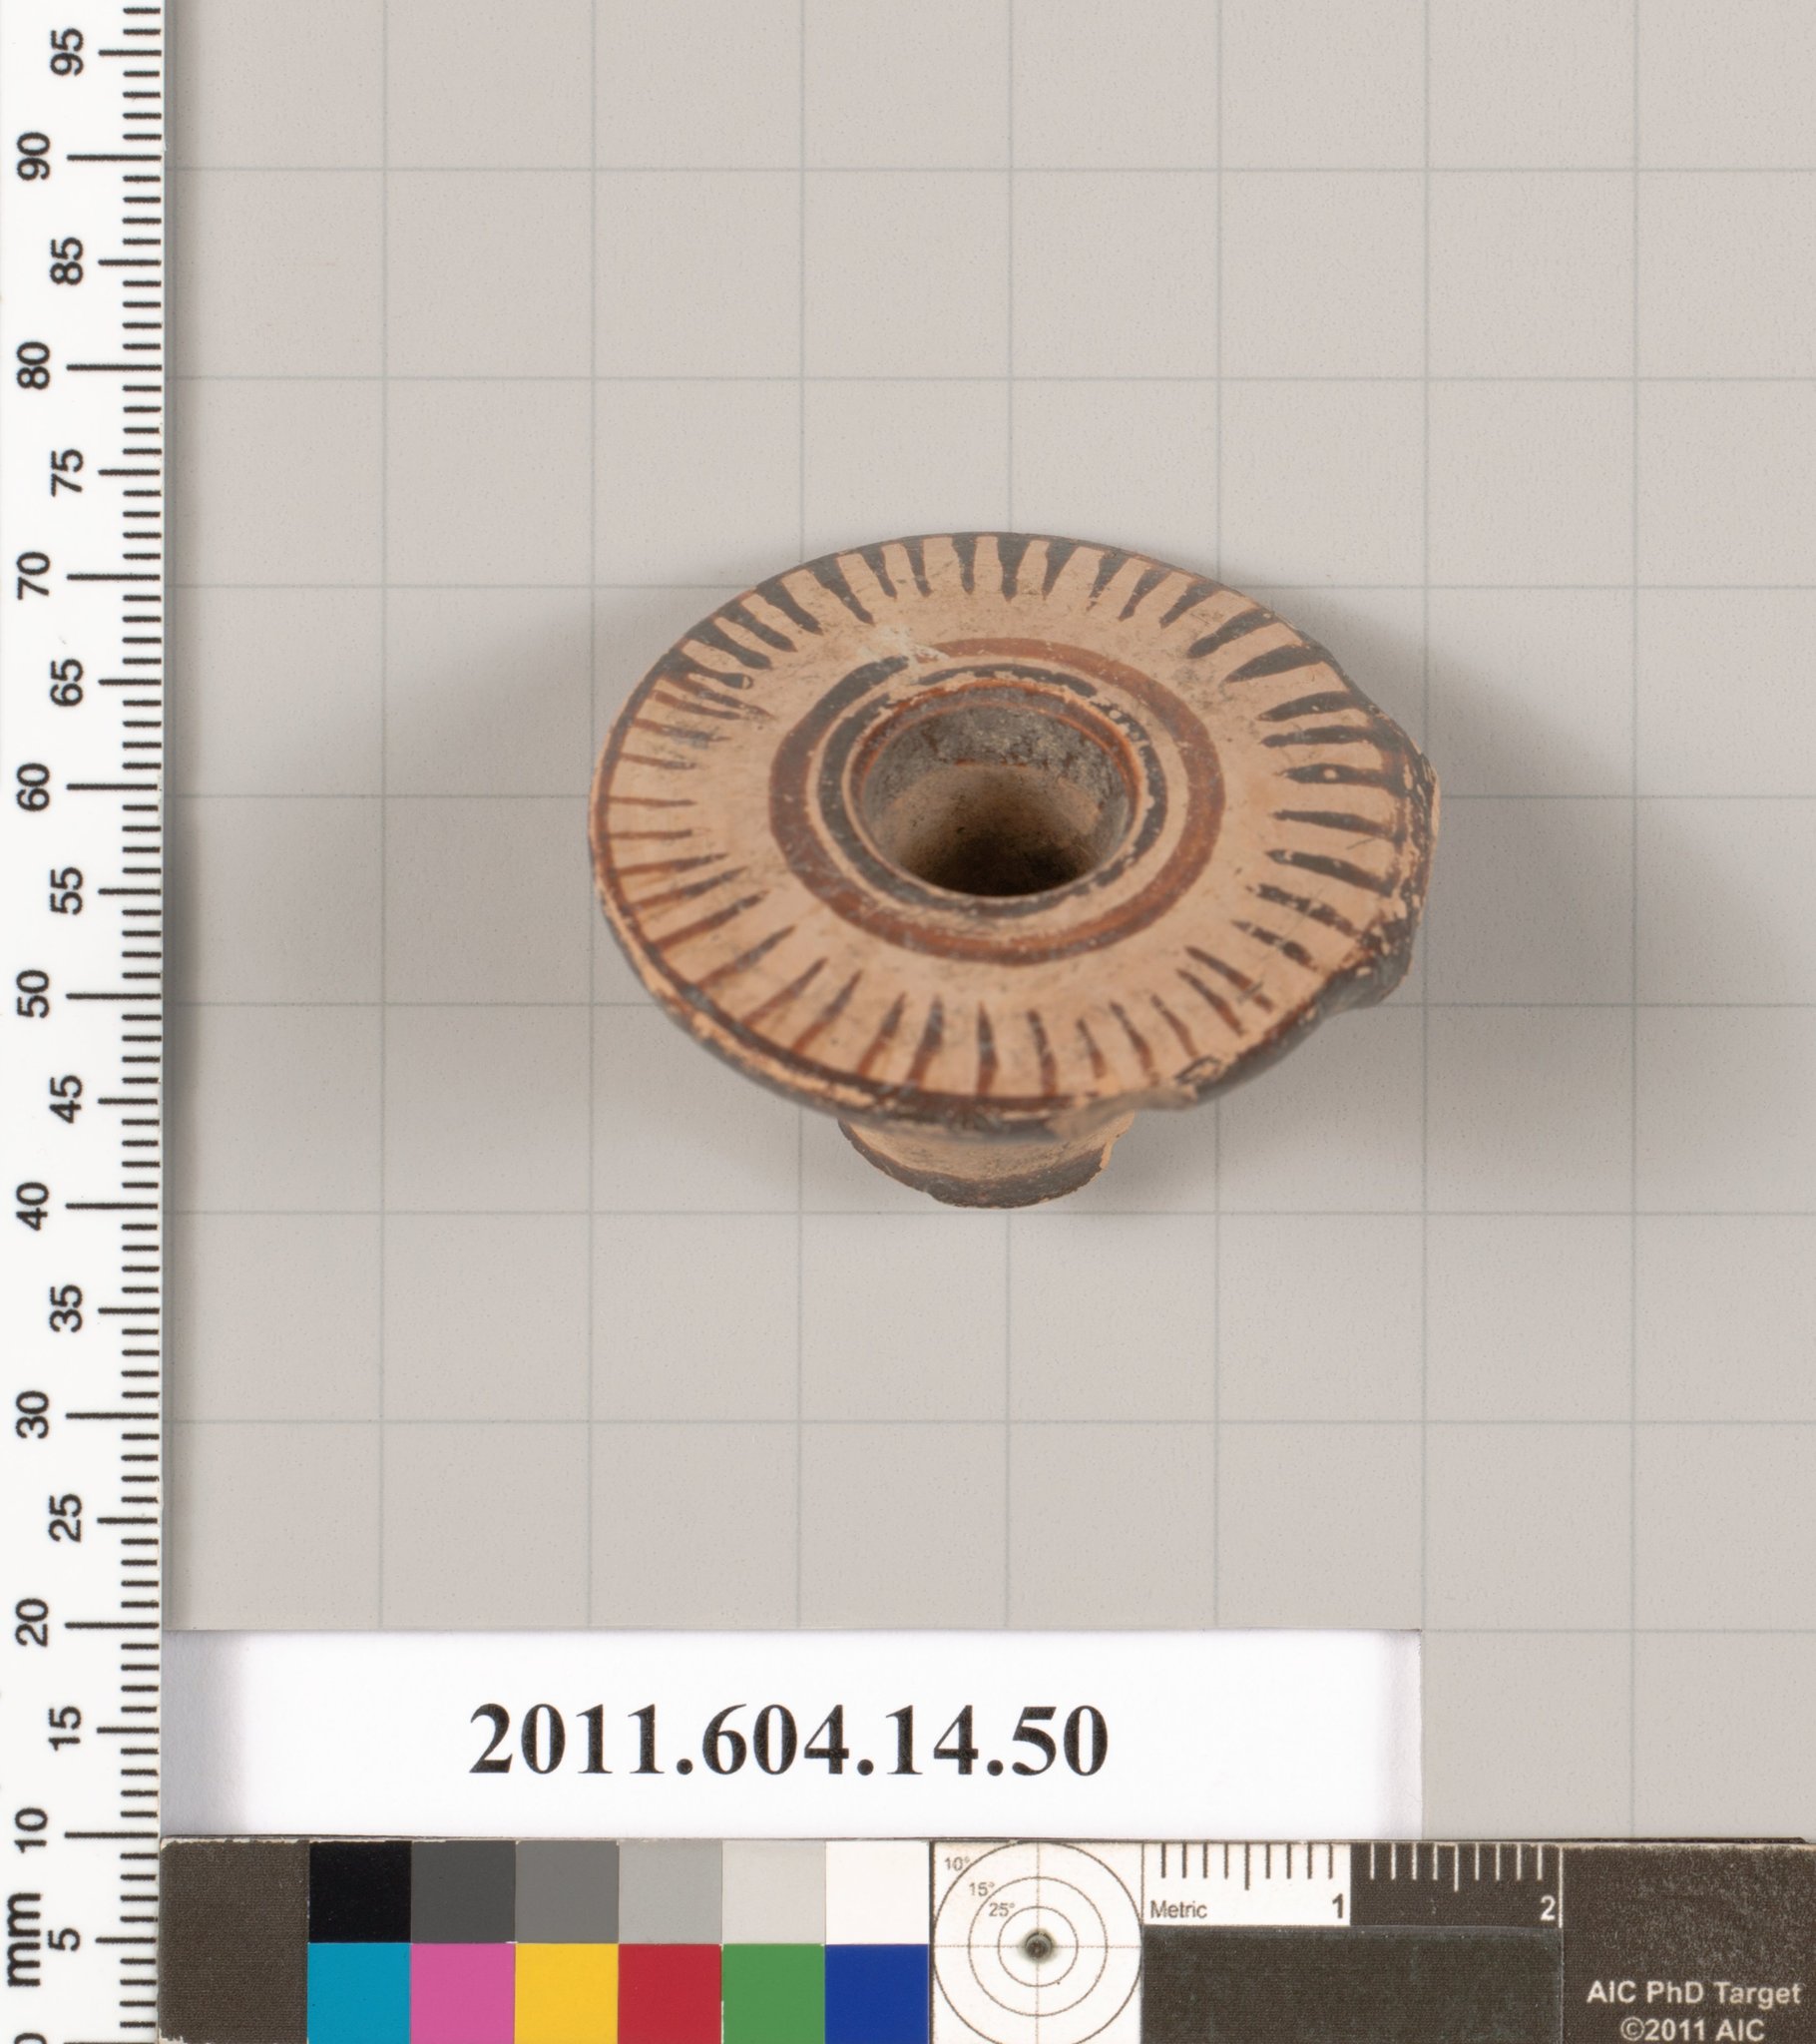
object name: alabastron fragment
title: Terracotta fragment of an alabastron?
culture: unknown fabric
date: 600-301 BCE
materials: terracotta